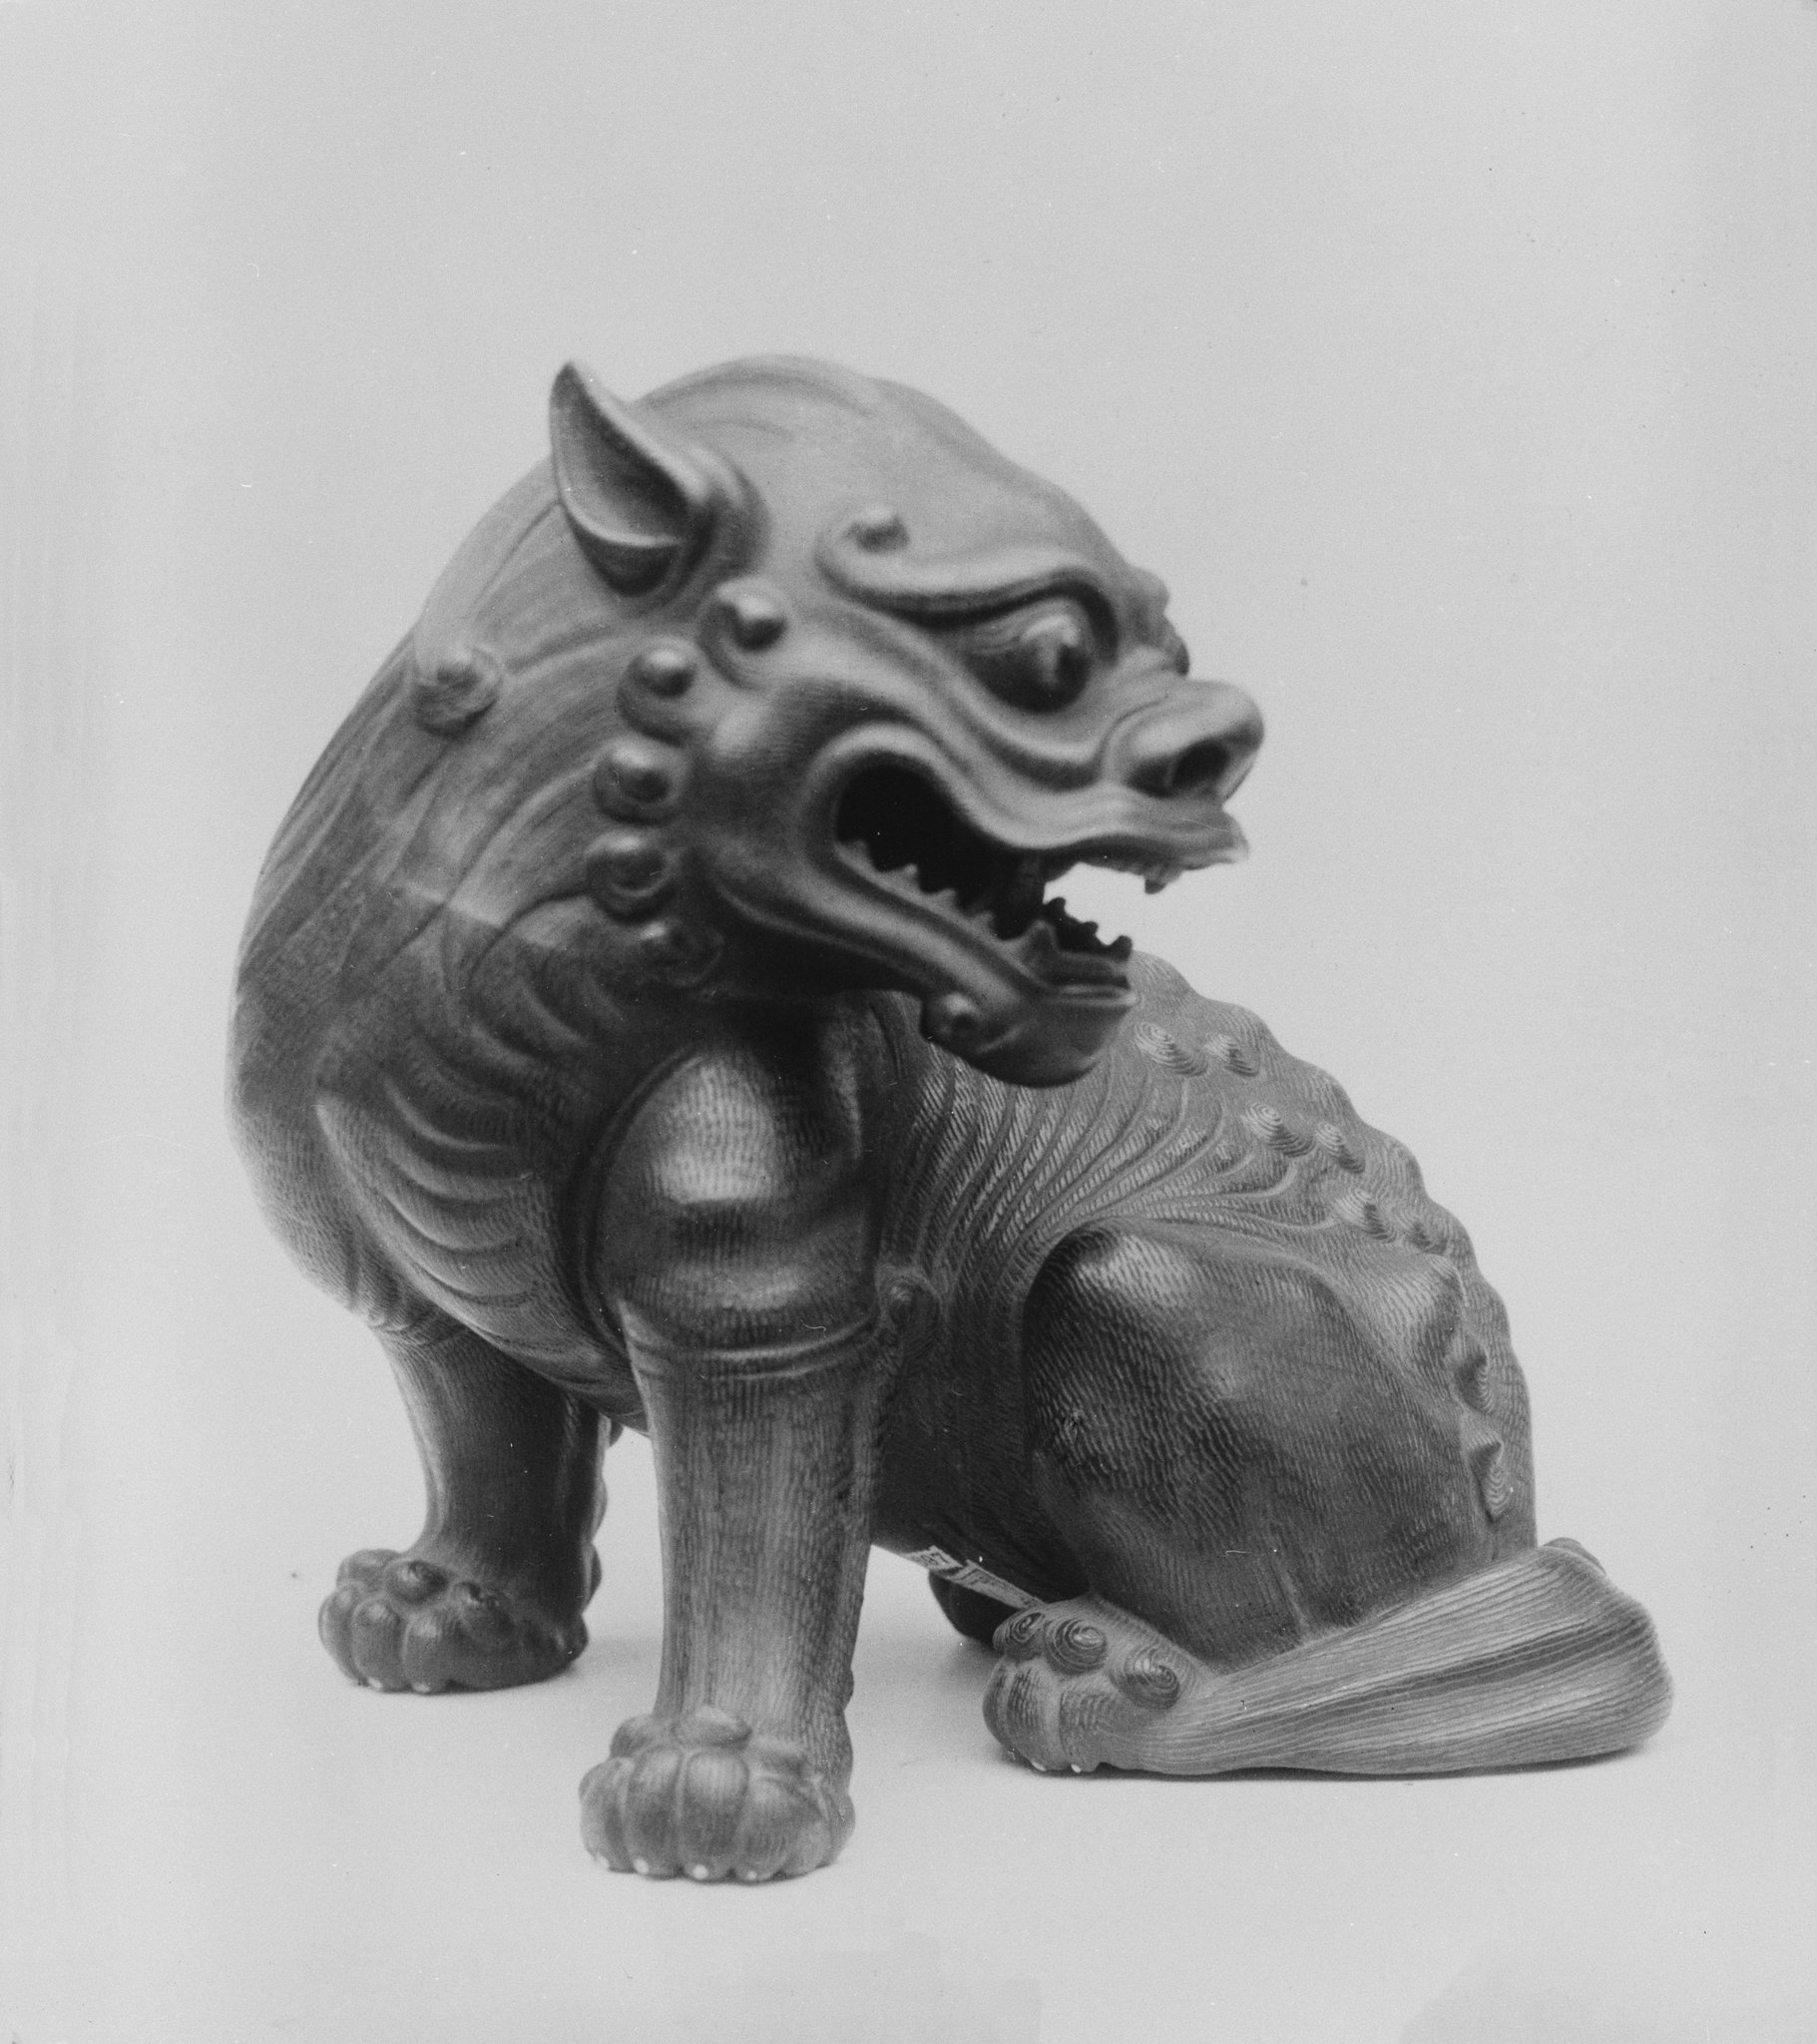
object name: figure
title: Figure (Shishi)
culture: japanese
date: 1800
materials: glaze, stoneware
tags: lions